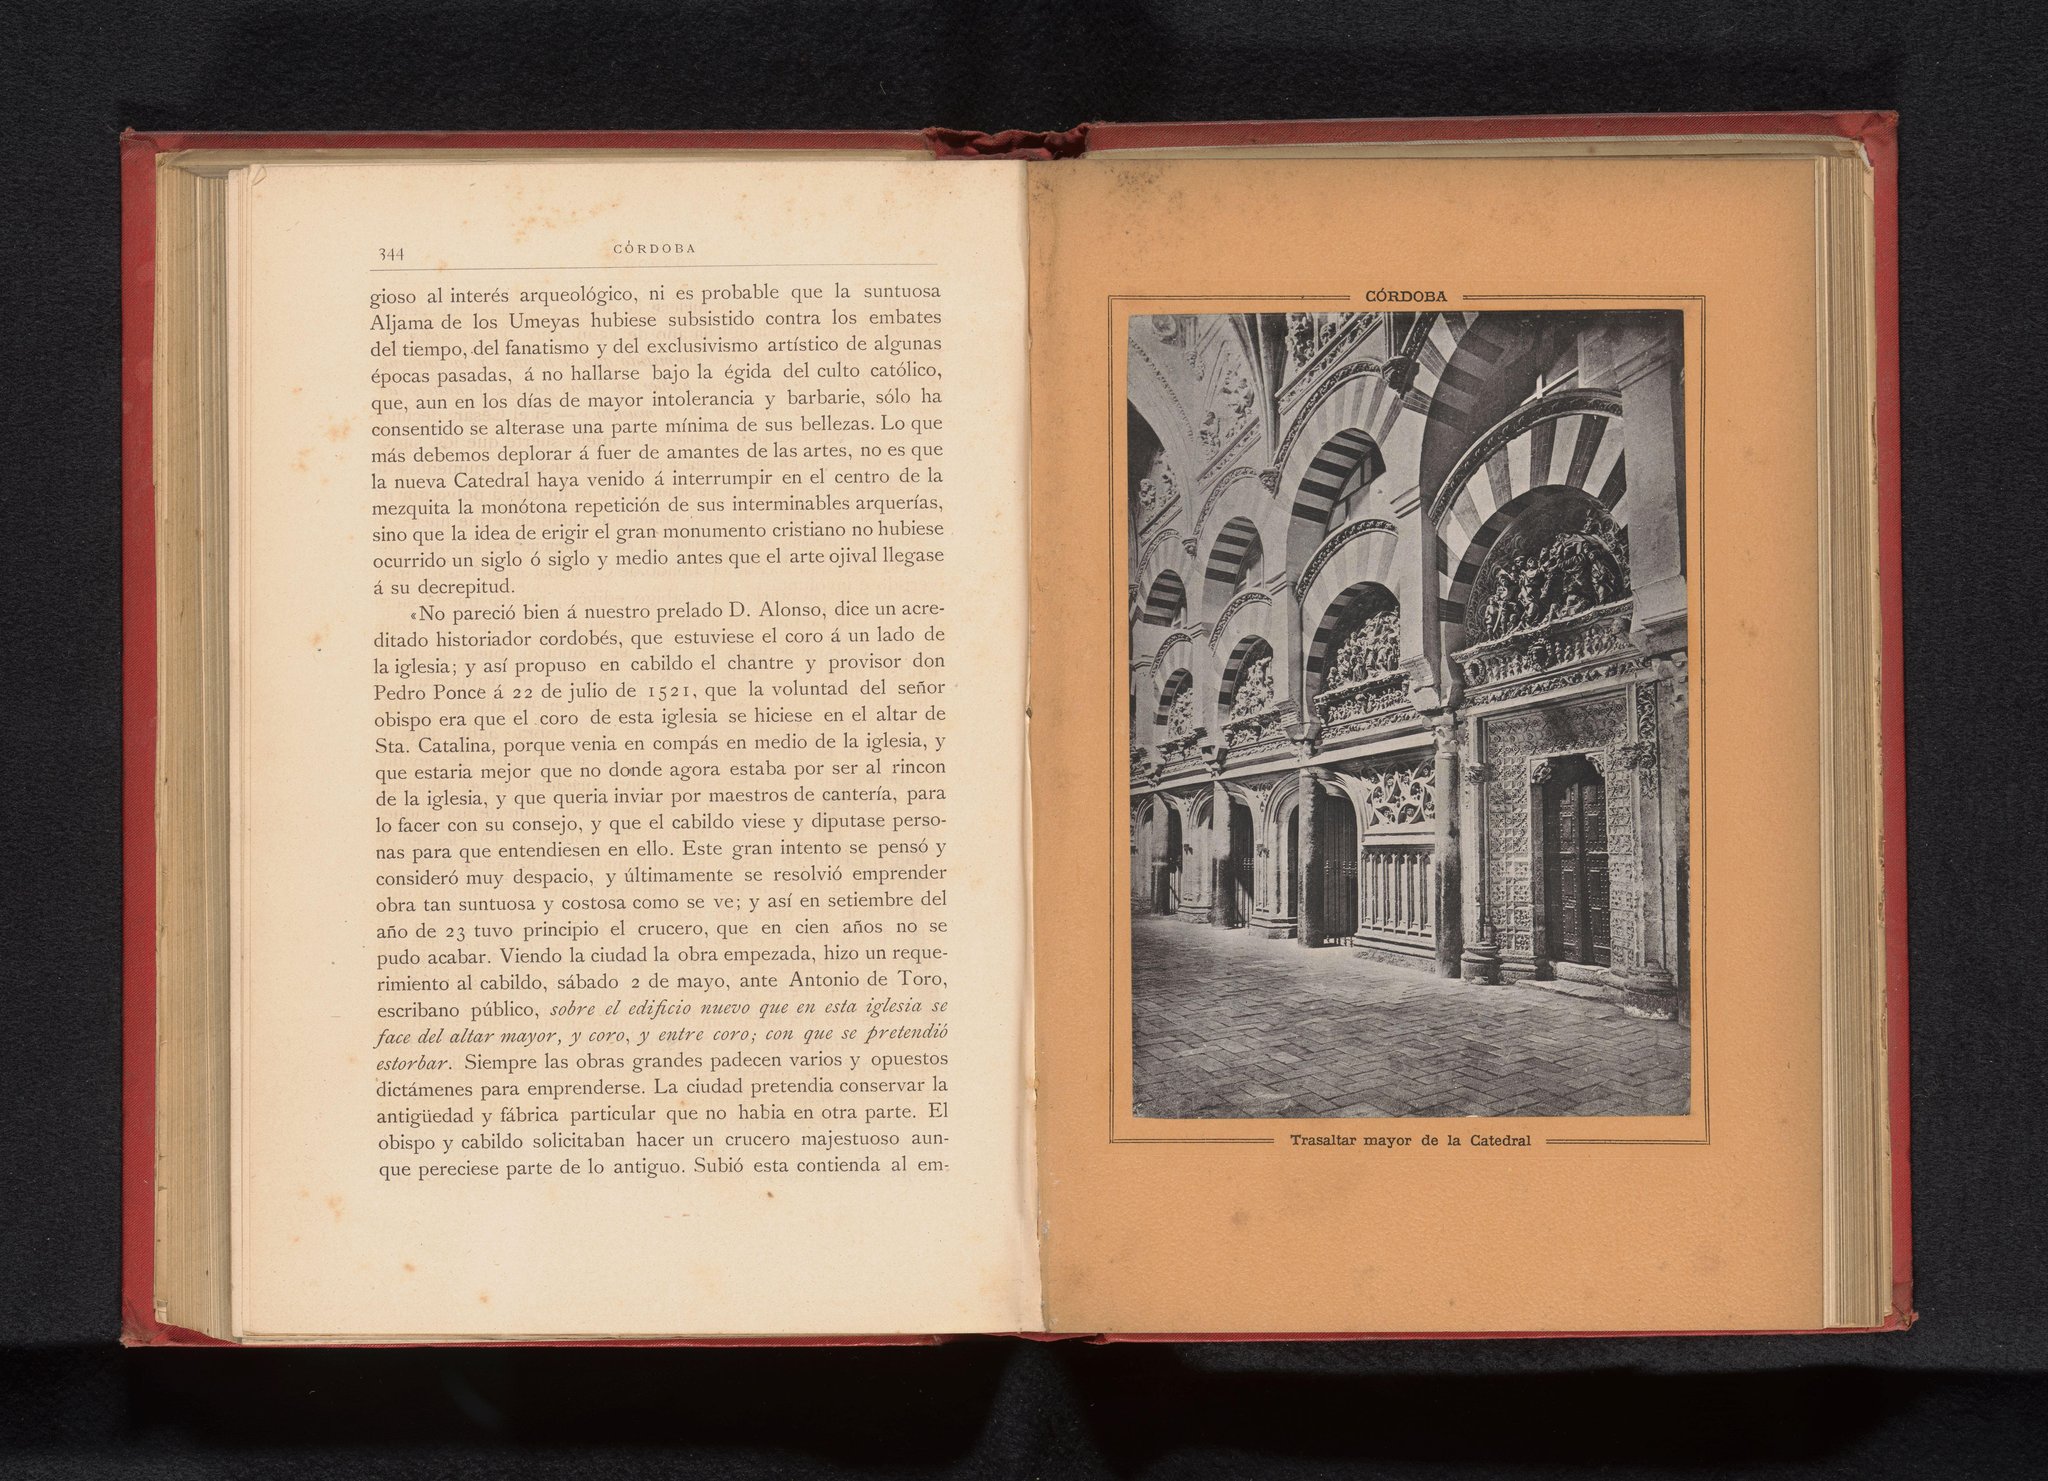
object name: photomechanical print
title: Trasaltar mayor de la Catedral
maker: Anonymous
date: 1874-1884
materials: paper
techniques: photograph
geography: mezquita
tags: interior of church